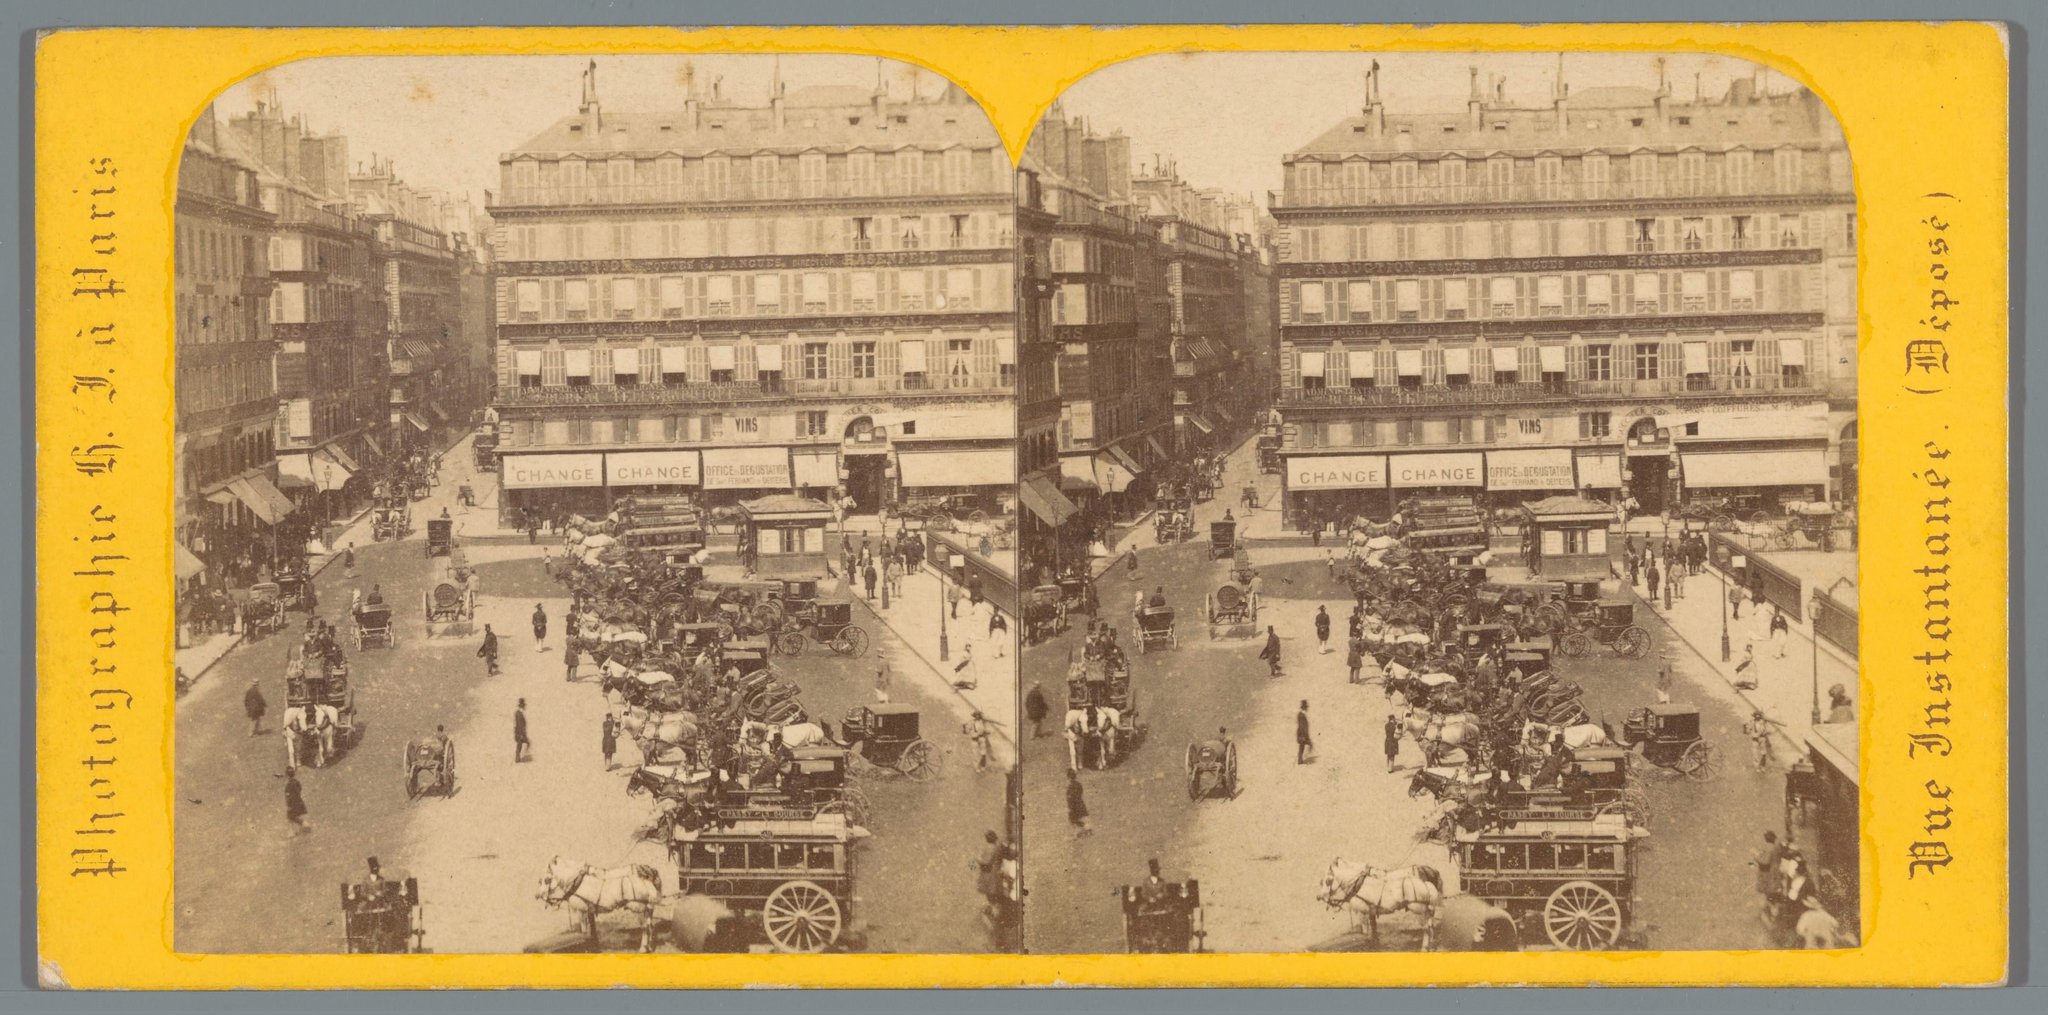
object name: stereograph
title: Gezicht op Place de la Bourse in Parijs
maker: hippolyte jouvin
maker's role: fotograaf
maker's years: 1825-1889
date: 1850-1880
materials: cardboard, photographic support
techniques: albumen print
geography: paris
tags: square, place, circus, etc., animal traction, animal-drawn vehicle (carriage etc.)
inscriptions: name: ‘Mon E. Vimard 180.R.de.Rivoli’, number: ‘No 89’